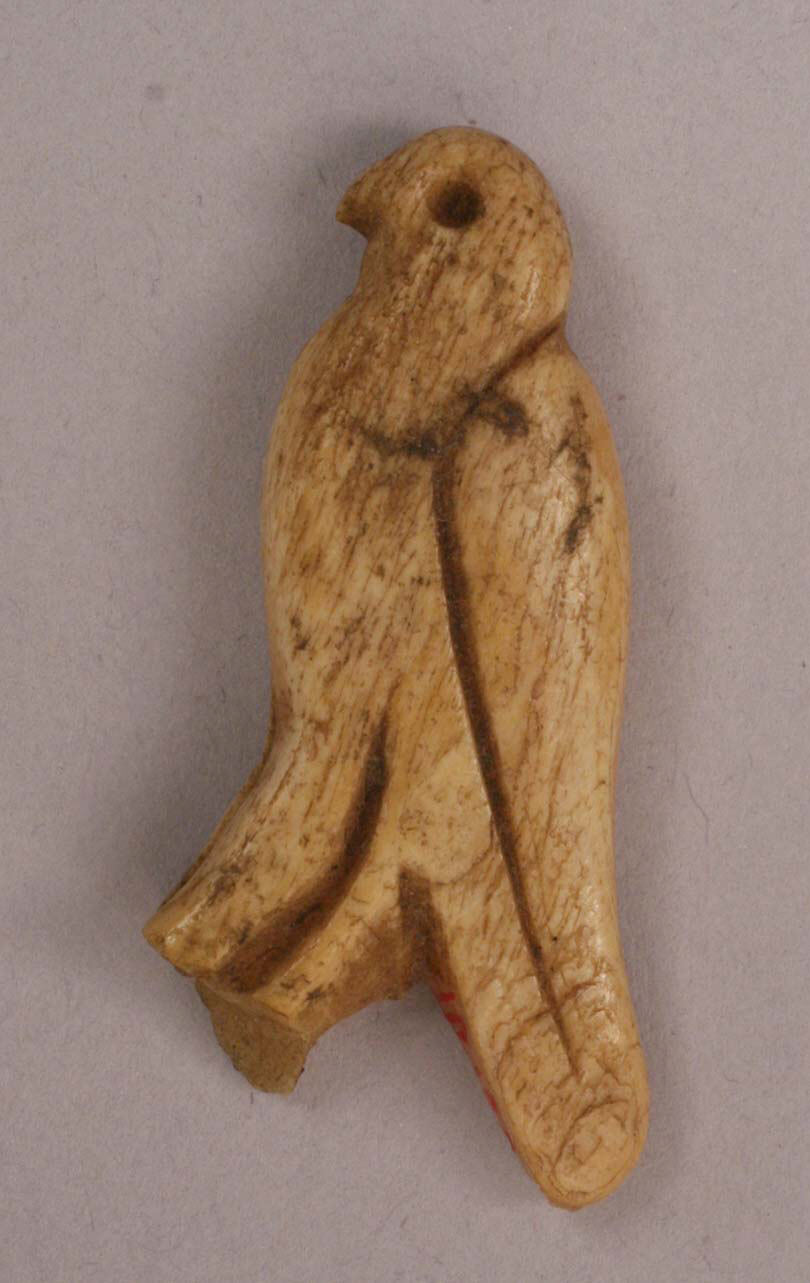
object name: figure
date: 30 BCE-364 CE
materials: ivory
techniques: incising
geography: egypt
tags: birds